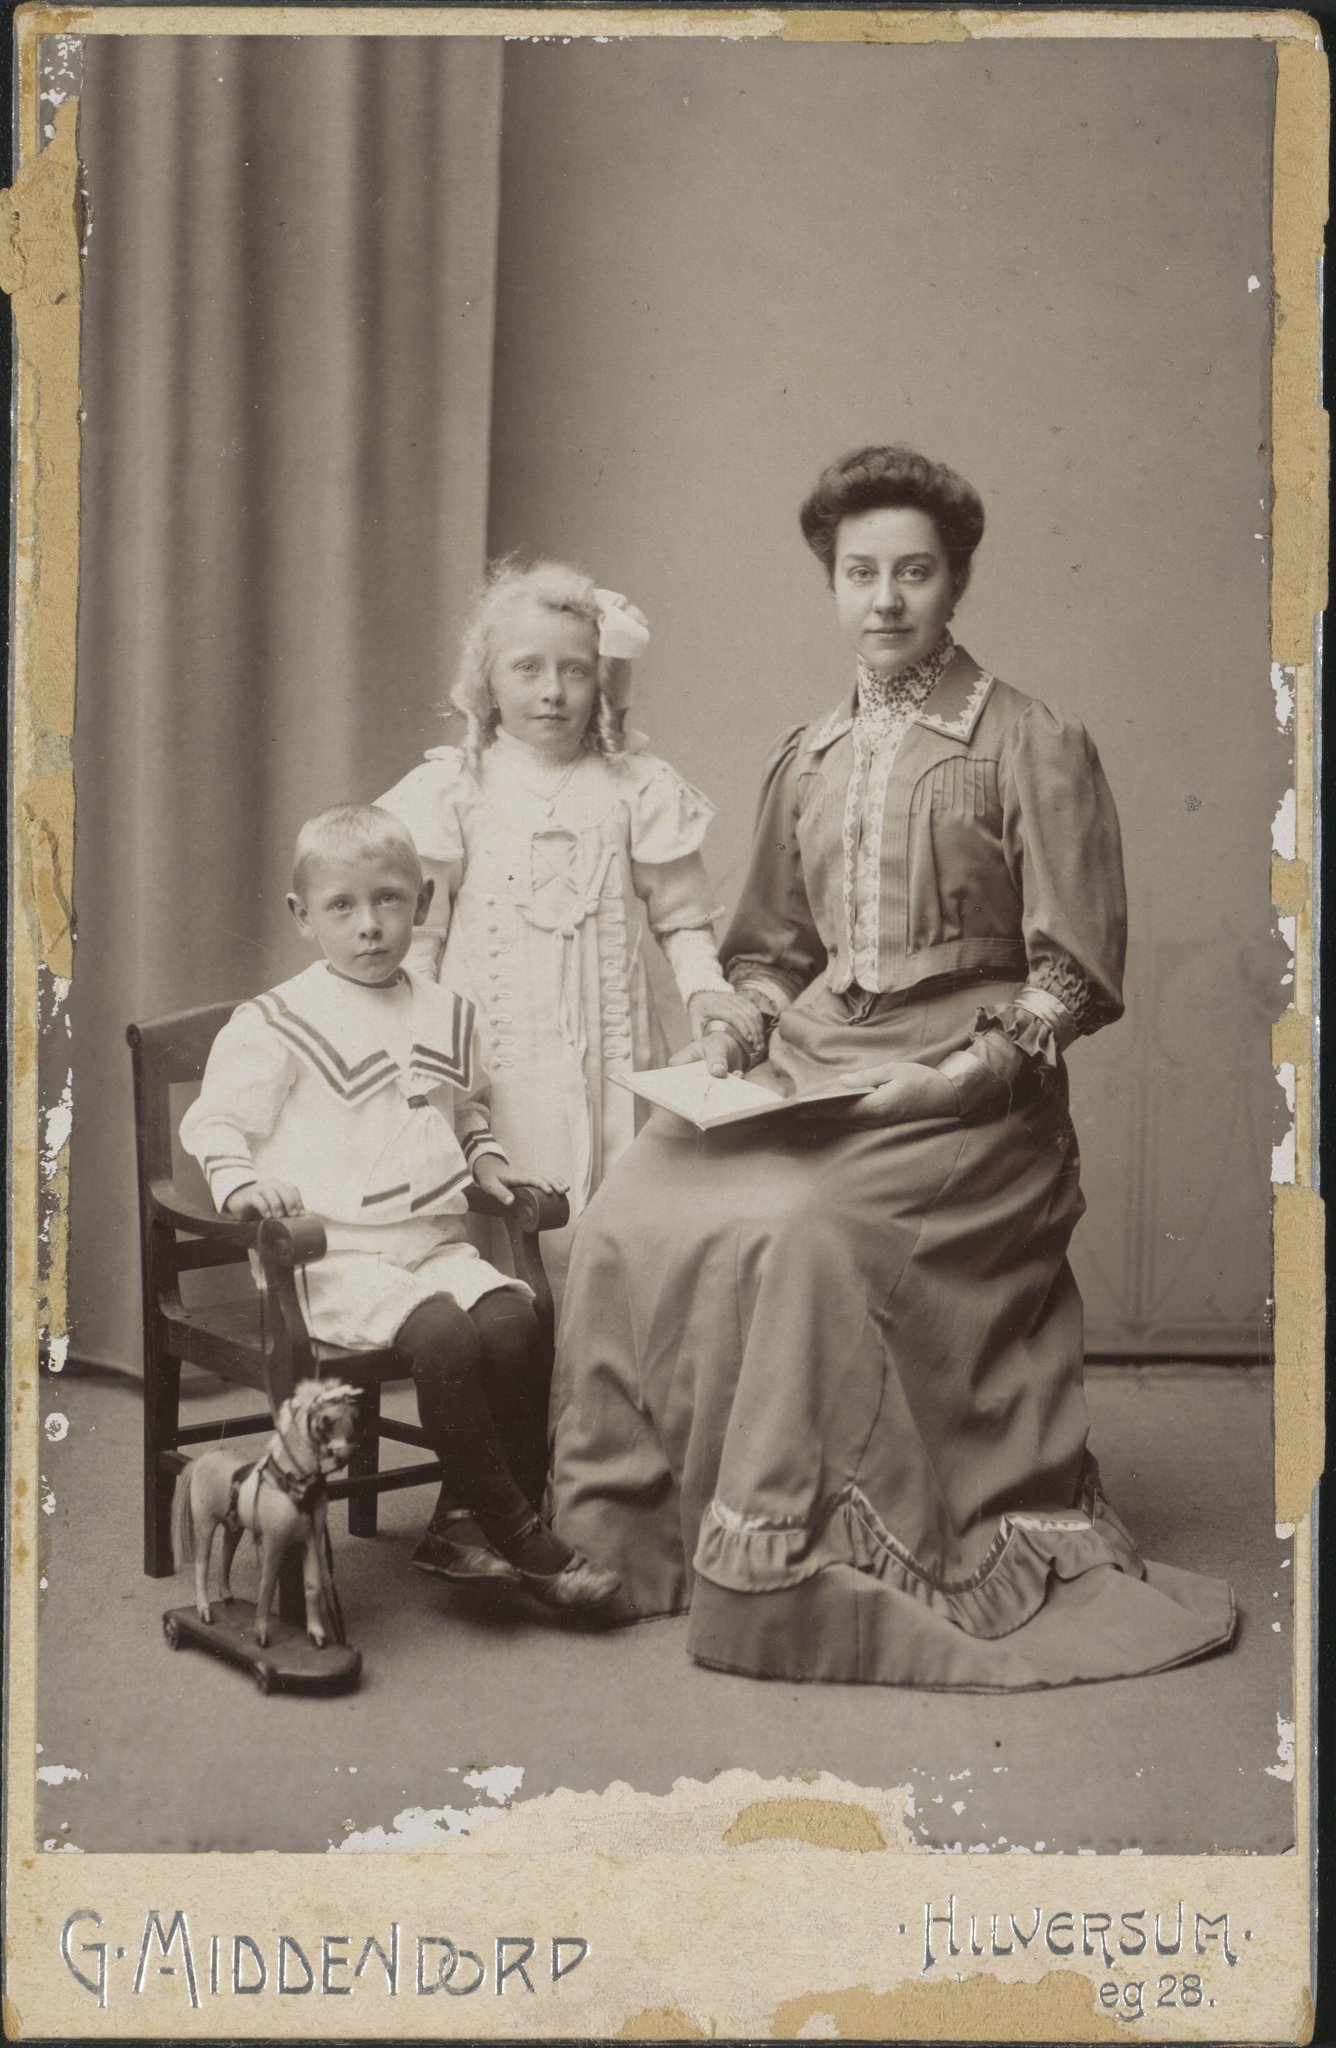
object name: cabinet photograph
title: Portret van jonge moeder met haar dochter en zoon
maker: johannes gerard middendorp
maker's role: fotograaf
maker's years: 1870-1949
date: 1895-1914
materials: cardboard, paper, photographic support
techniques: collodion silver print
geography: hilversum